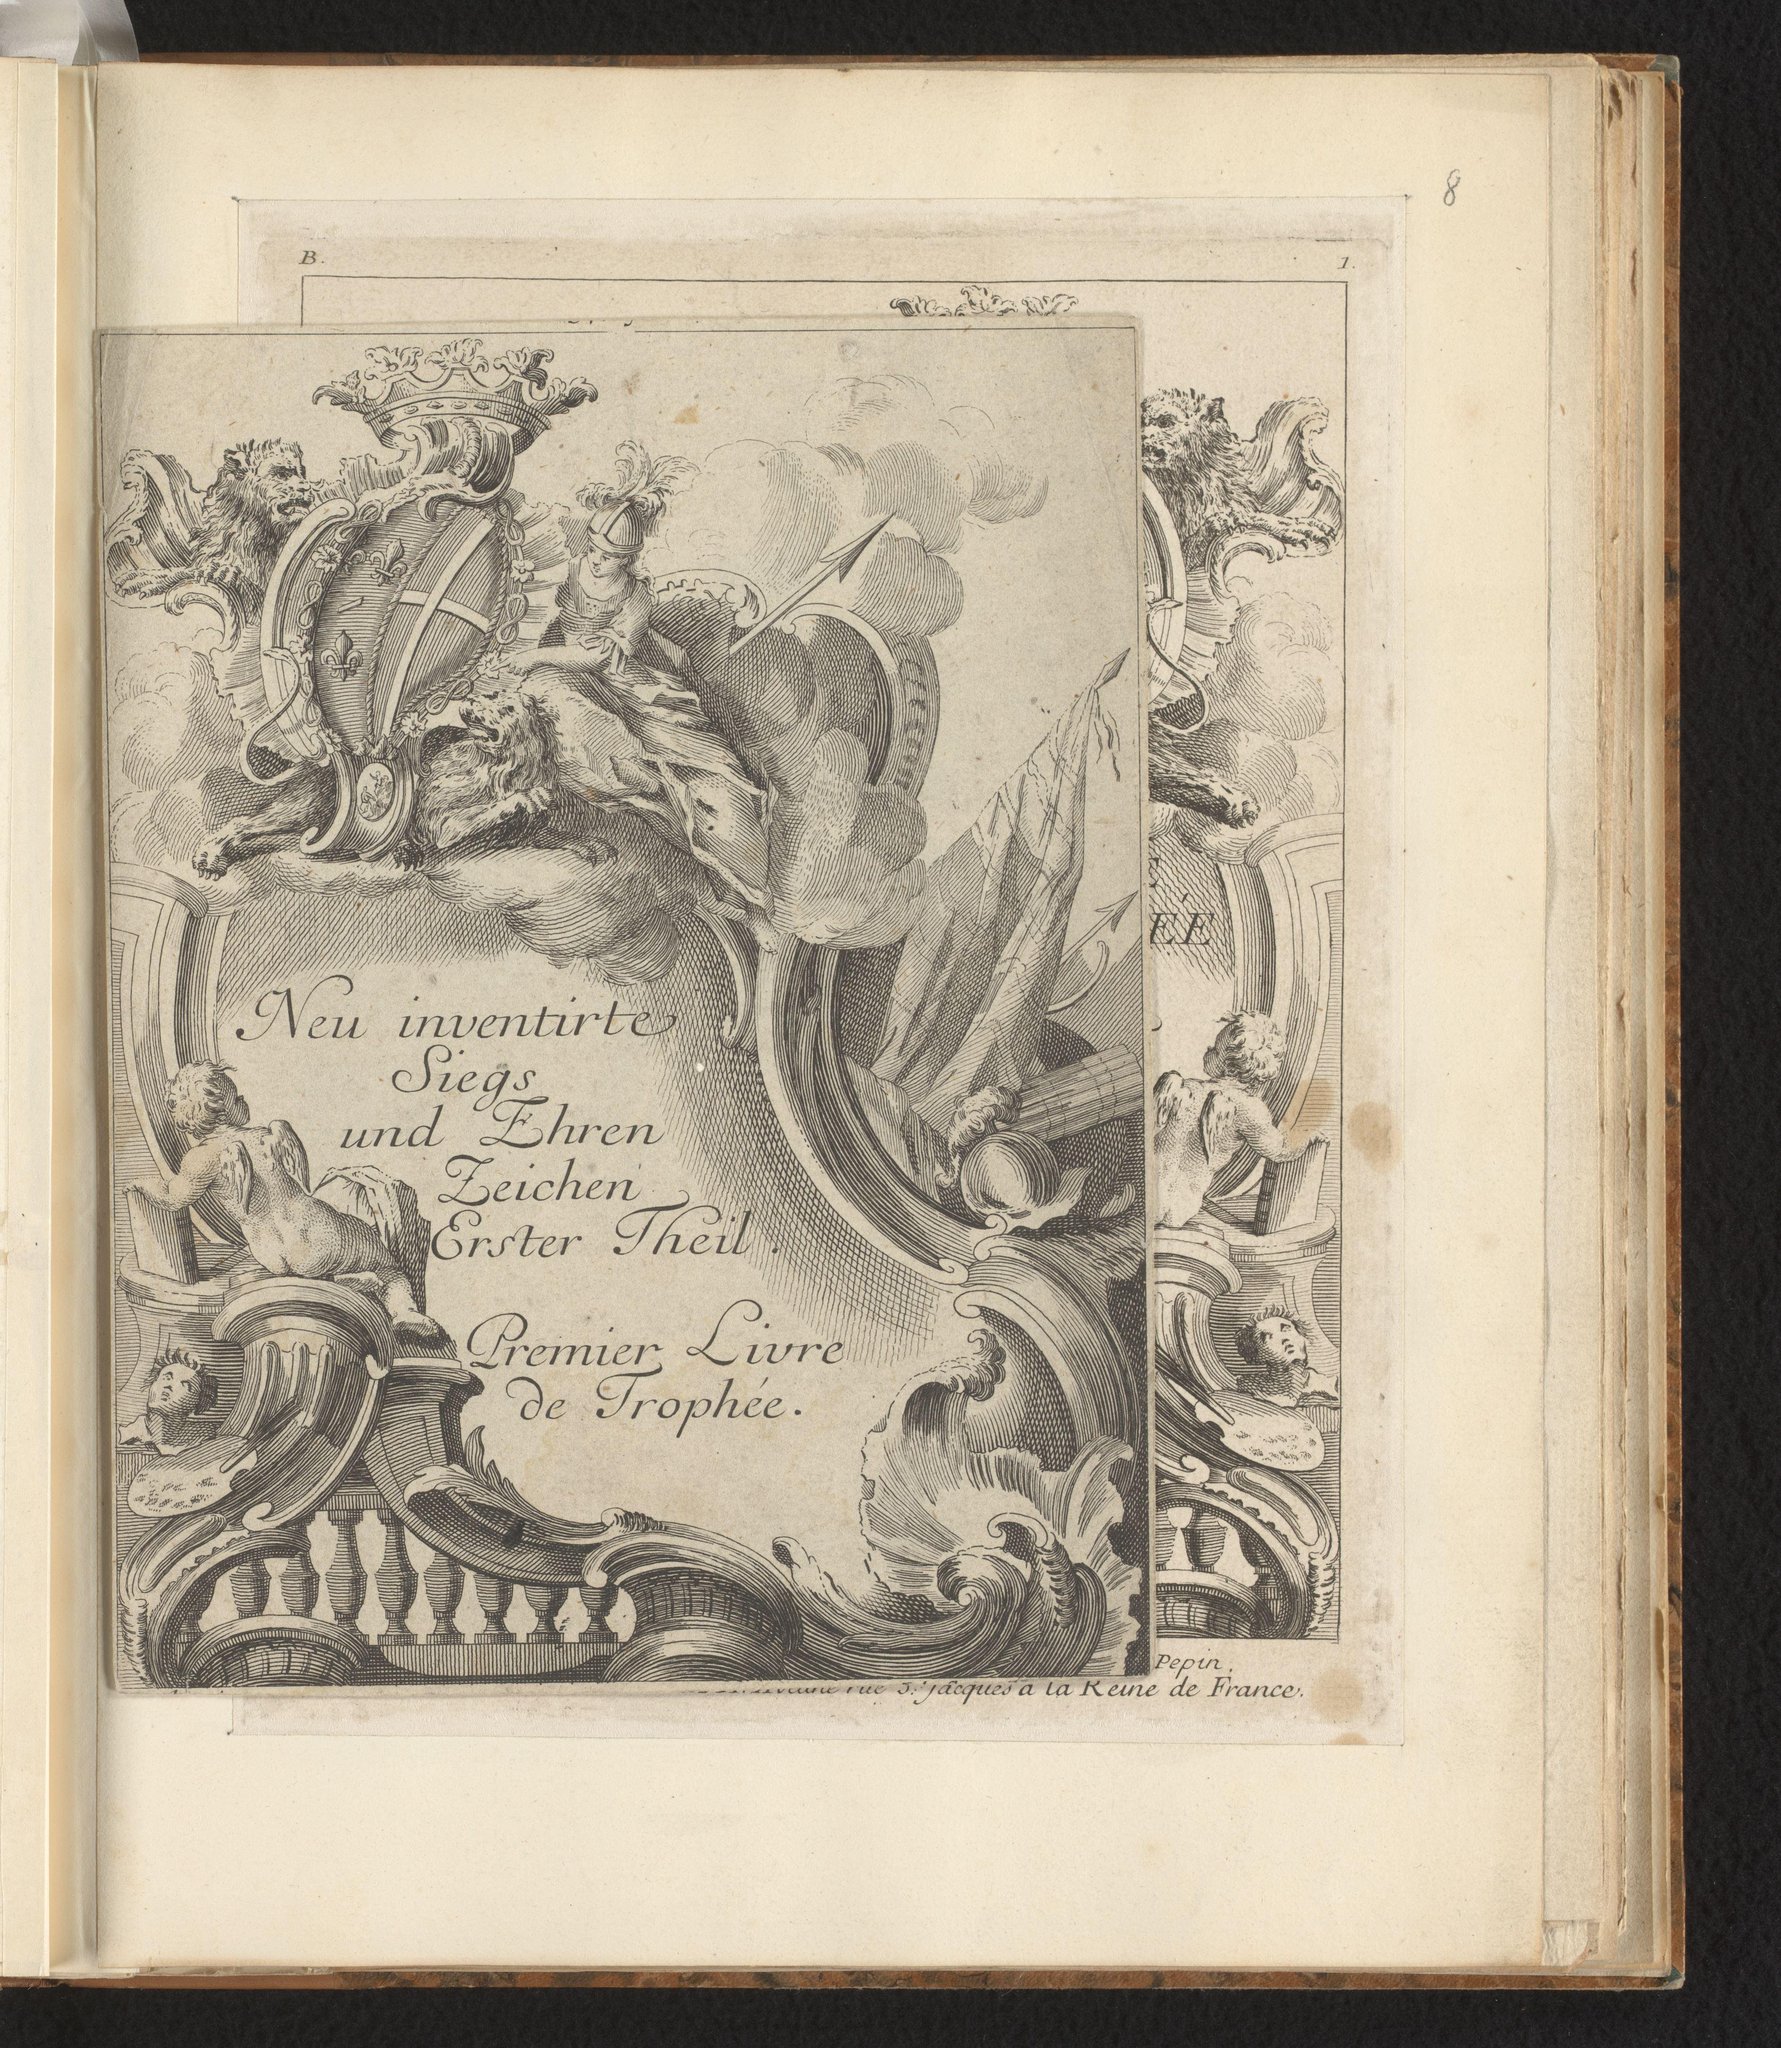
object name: ornament print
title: Neu inventirte Siegs und Ehren Zeichen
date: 1736-1762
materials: paper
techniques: engraving, etching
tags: rocaille ornament, trophy ~ battle, war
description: Prent ligt los in het album, voor de pagina met objectnummer RP-P-2002-237 waarvan deze prent een gespiegelde kopie is.